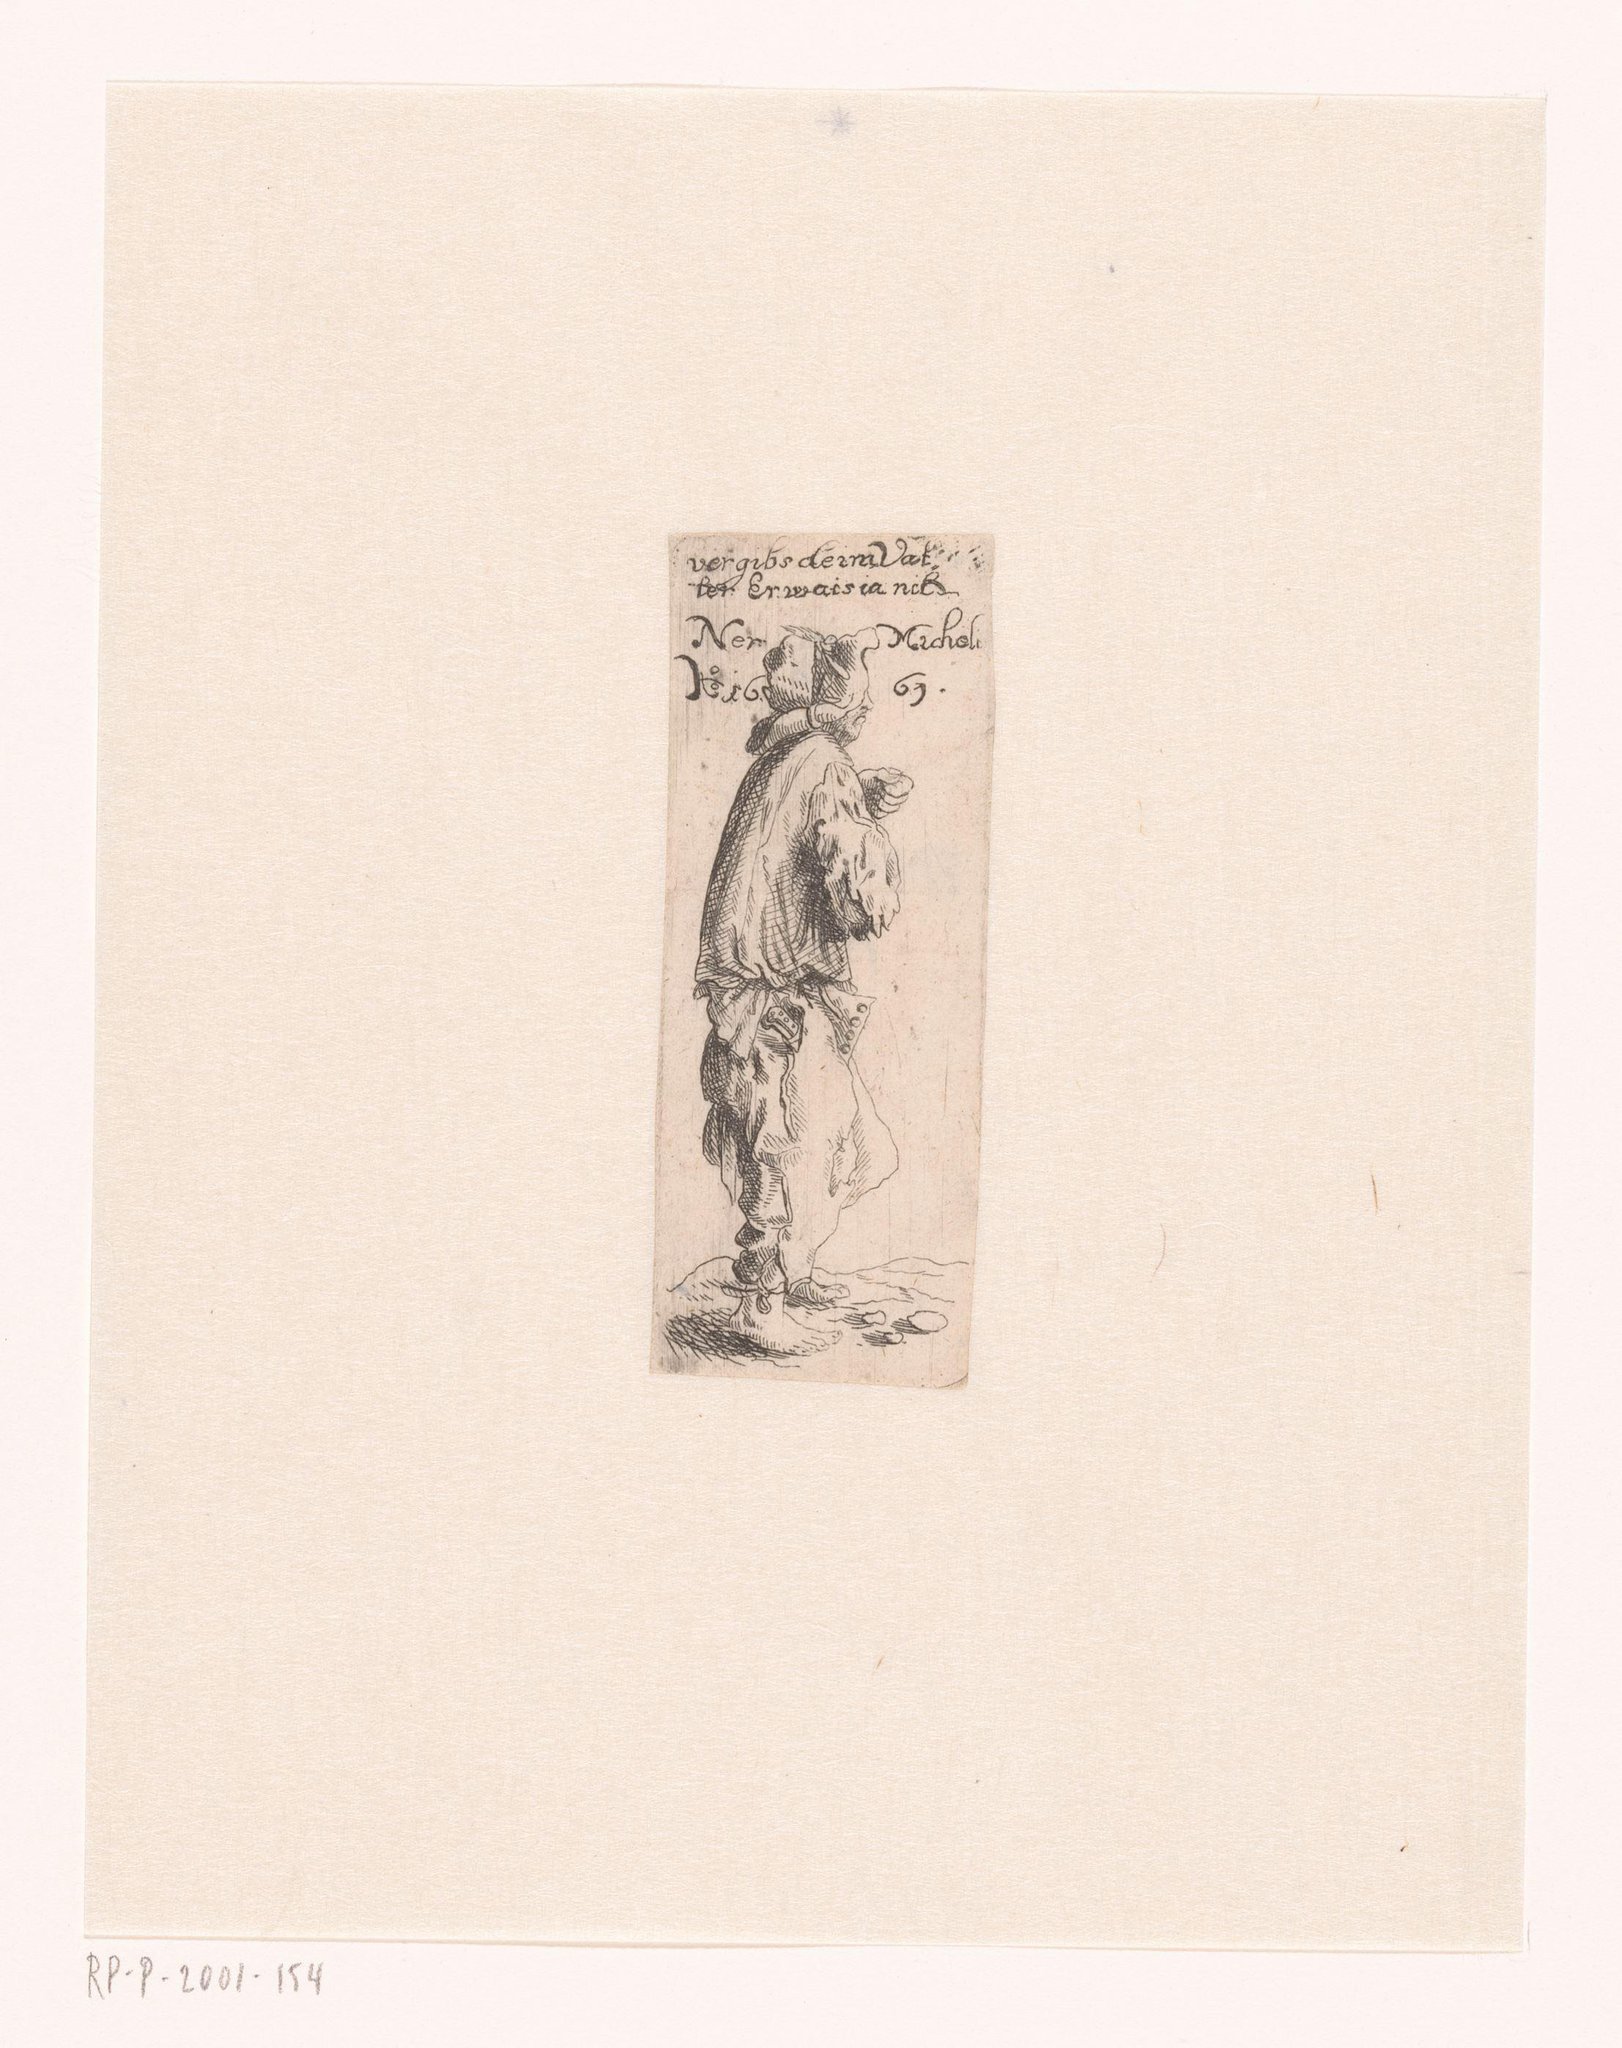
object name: print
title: Arme man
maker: ner micheli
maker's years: 1659-1669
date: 1669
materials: paper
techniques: etching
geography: germany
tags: clothed in rags, tools, aids, implements ~ crafts and industries: knife, the poor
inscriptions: signature and date: ‘Ner Micheli / 1669’, collector's mark: Lugt 2233, collector's mark: Lugt 2228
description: Staande man, naar rechts, met hoed op. Zijn kleren zijn versleten, hij heeft een mes in zijn zak. Boven zijn hoofd de tekst: vergibs dein Vat/ter Er wais ja nich.